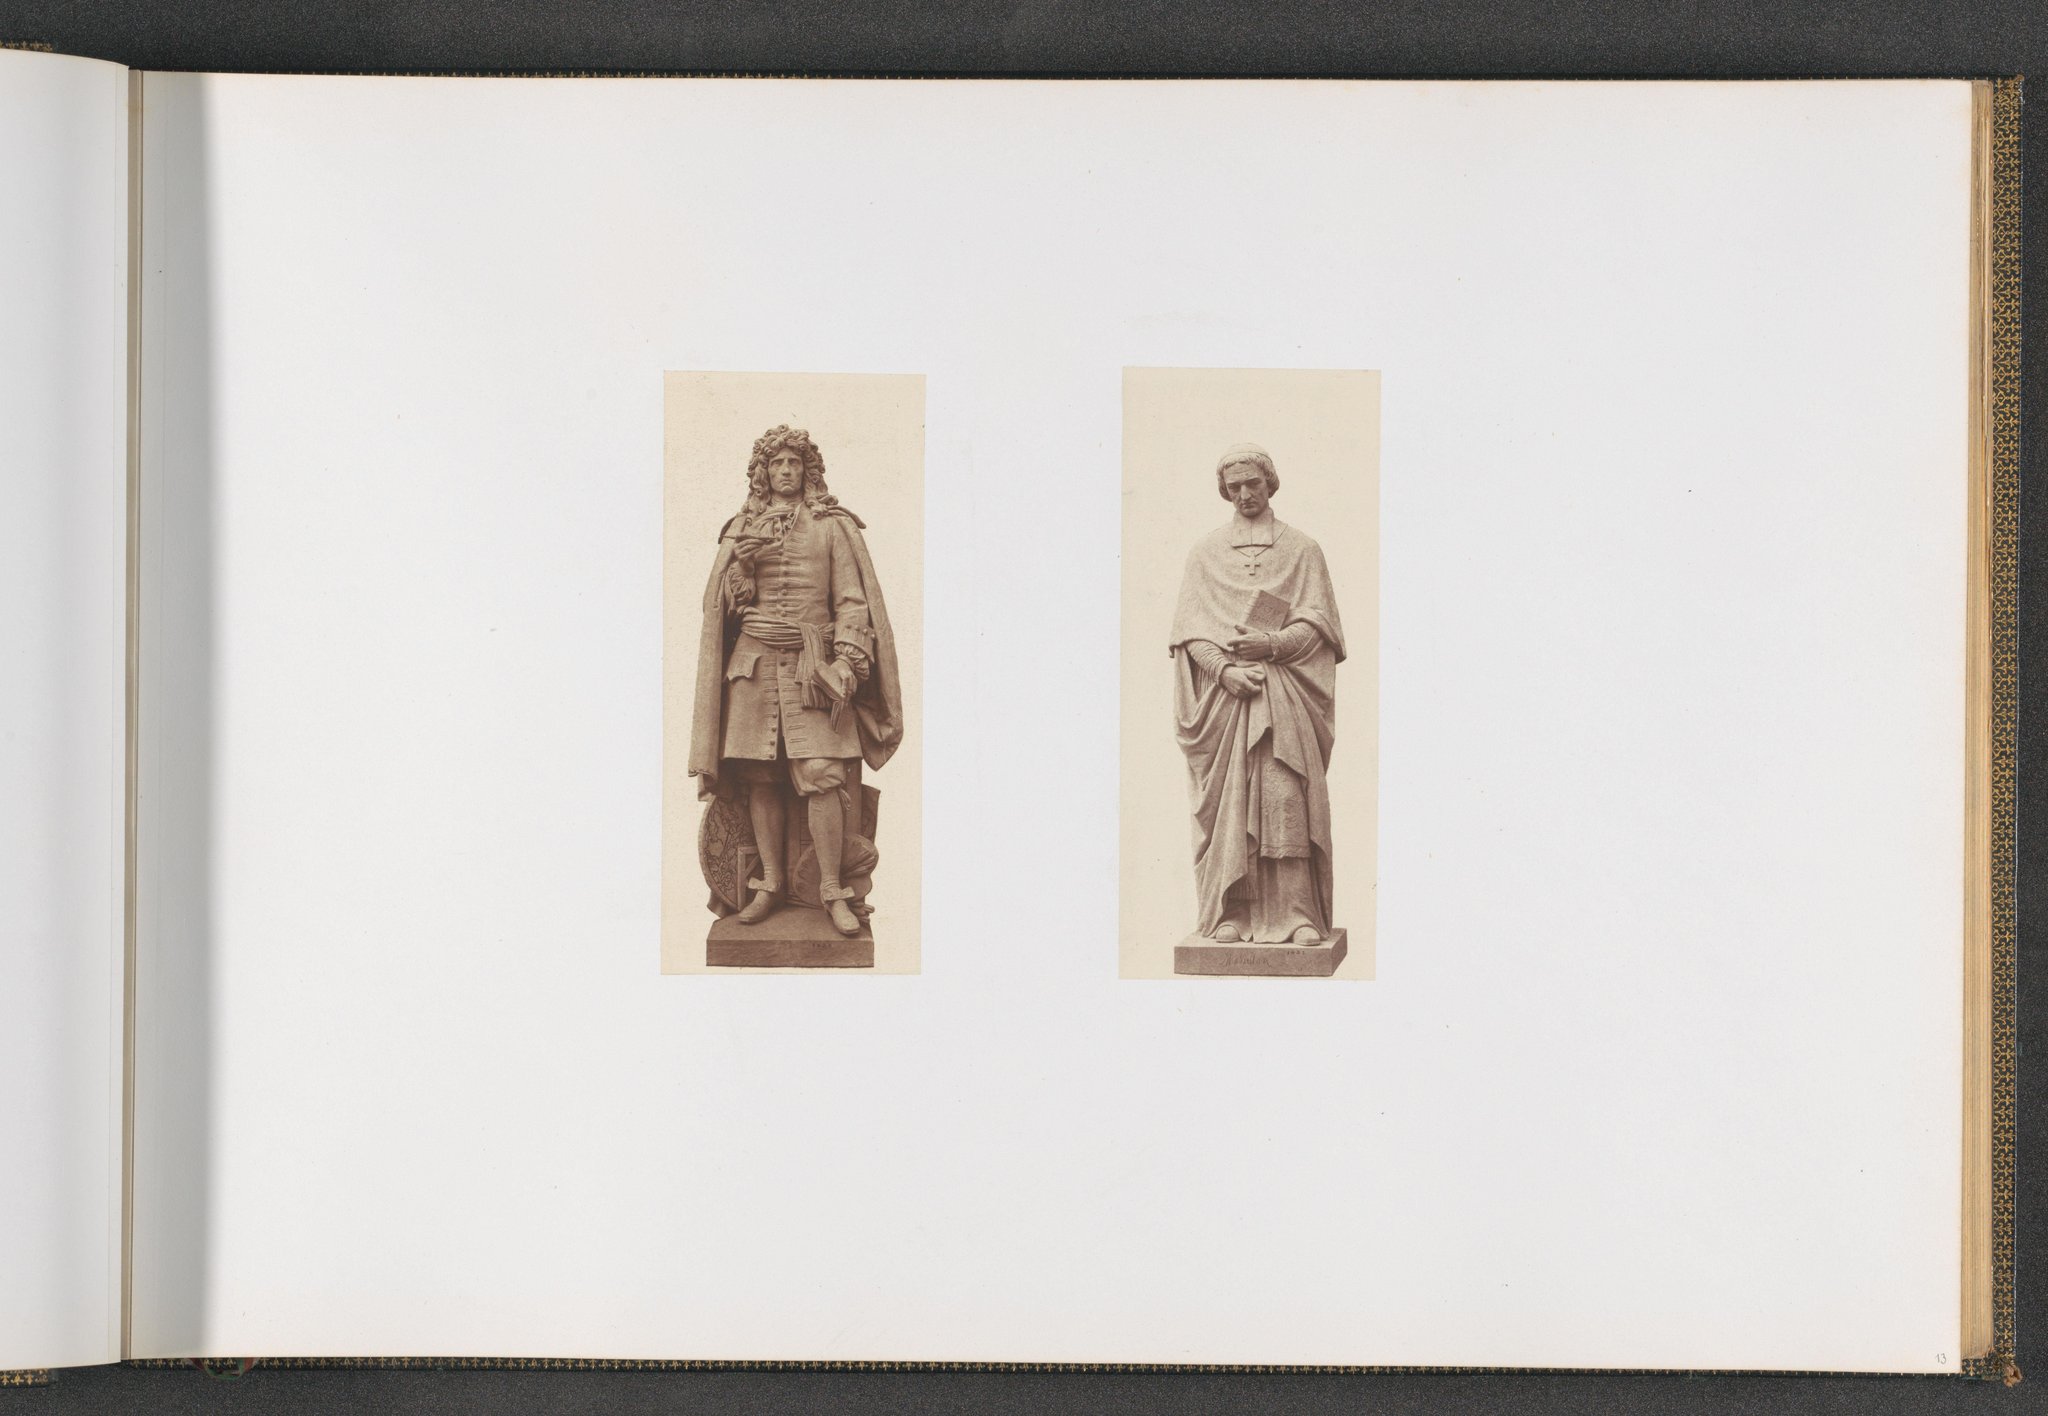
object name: photograph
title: Gipsmodellen voor beeldhouwwerken op het Palais du Louvre: links "Mignard" door Jean Baptiste Joseph de Bay en rechts "Massillon" door François Jouffroy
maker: édouard denis baldus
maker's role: fotograaf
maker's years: 1813-1889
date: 1855-1857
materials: paper, photographic support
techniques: salted paper print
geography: paris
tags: piece of sculpture, reproduction of a piece of sculpture, permanent exhibition, museum, paris, tuileries palace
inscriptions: number: ‘1056 en 1057’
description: Onderdeel van Réunion des Tuileries au Louvre 1852-1857, album 2.